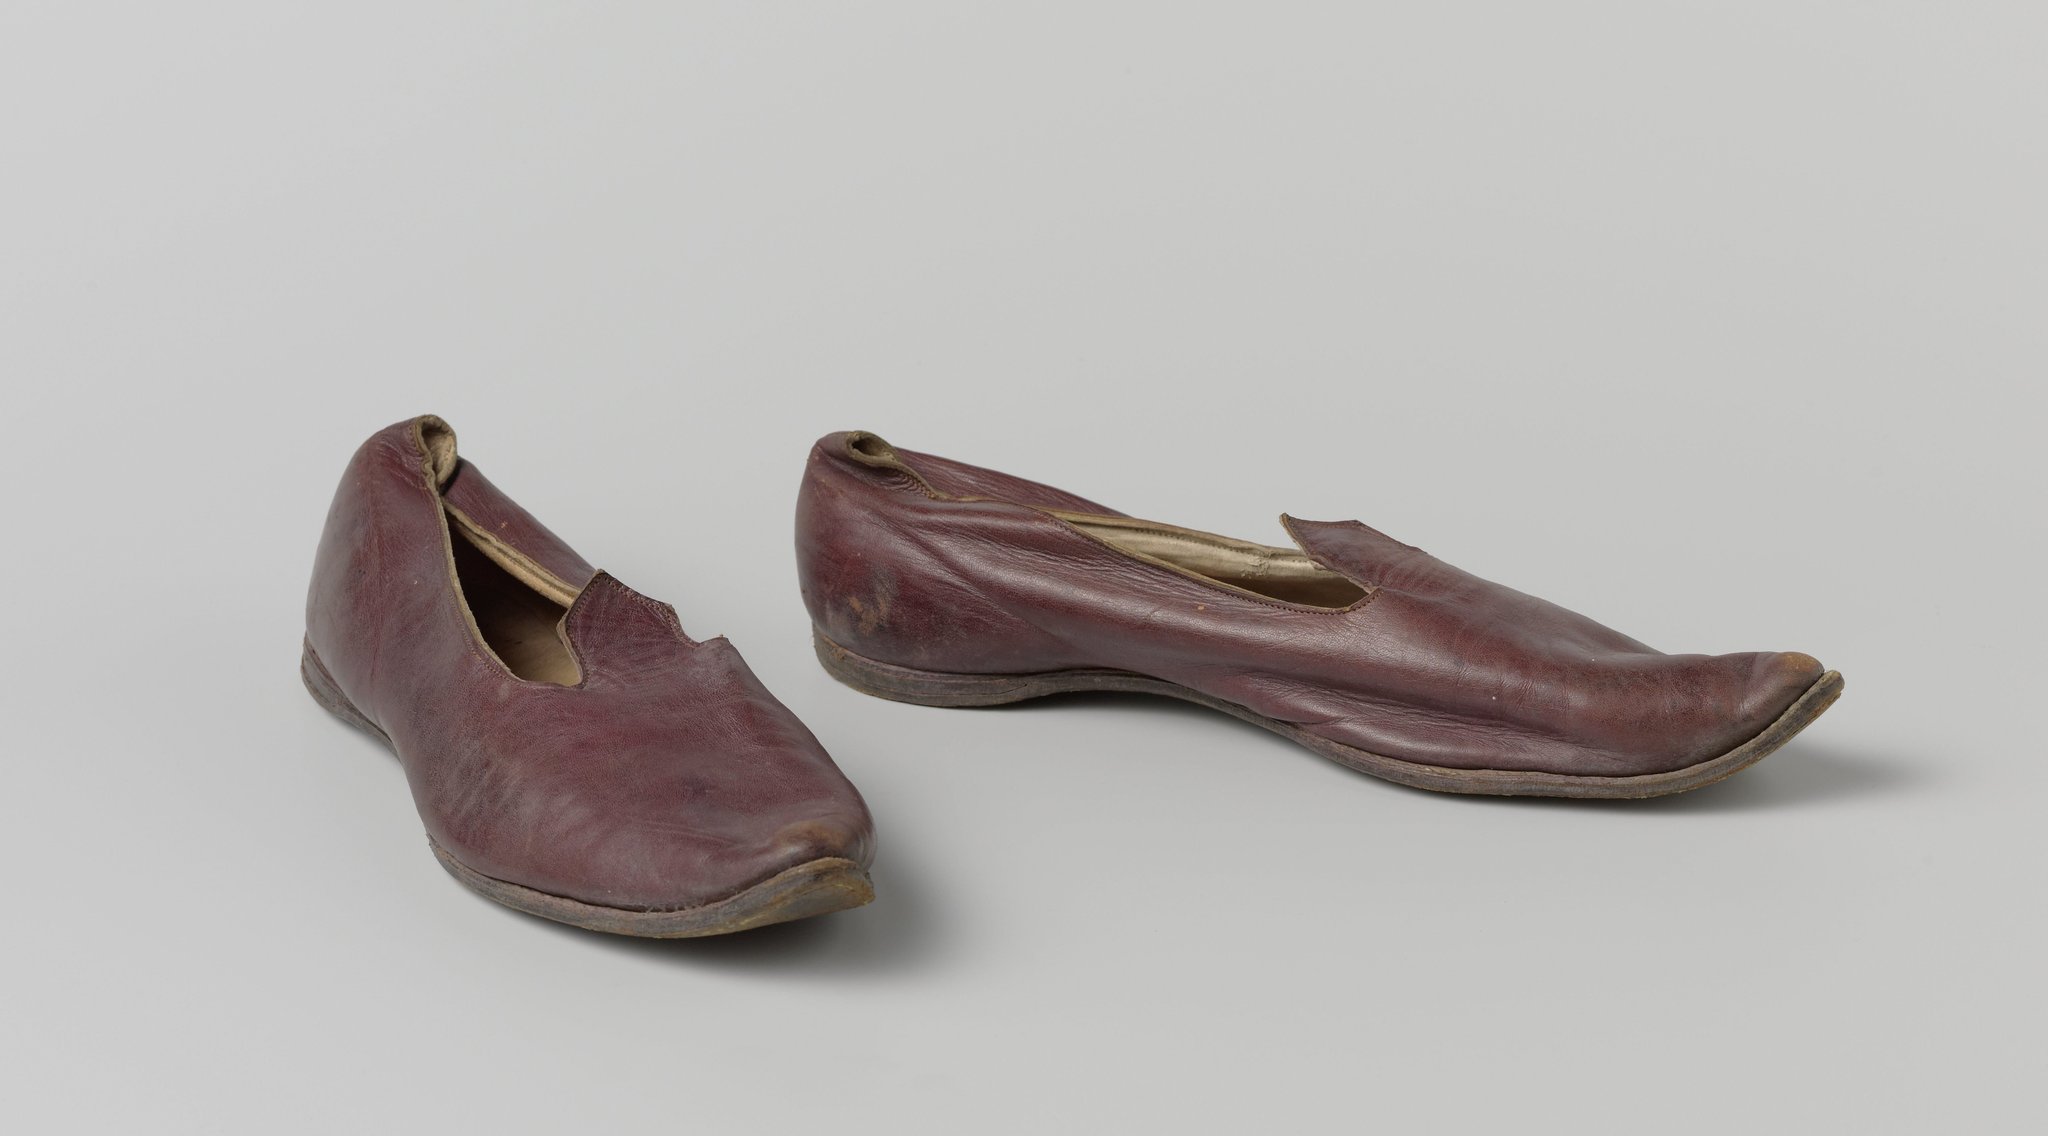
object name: shoe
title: Leren schoen van Perzisch maskeradekostuum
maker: Anonymous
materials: leather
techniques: quilting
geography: delft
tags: amsterdam, delft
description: 'Hiernevens f.200,- voor je pak...'; citaat uit brief van H.M.A.F. Six-Bosch Reitz aan haar zoon, Collectie Six Amsterdam, inv. 51993. Zie ook foto's van Six in kostuum in Collectie Six, Amsterdam, inv. 51993 en 'Regenten gekleed', afb.42, p.51..